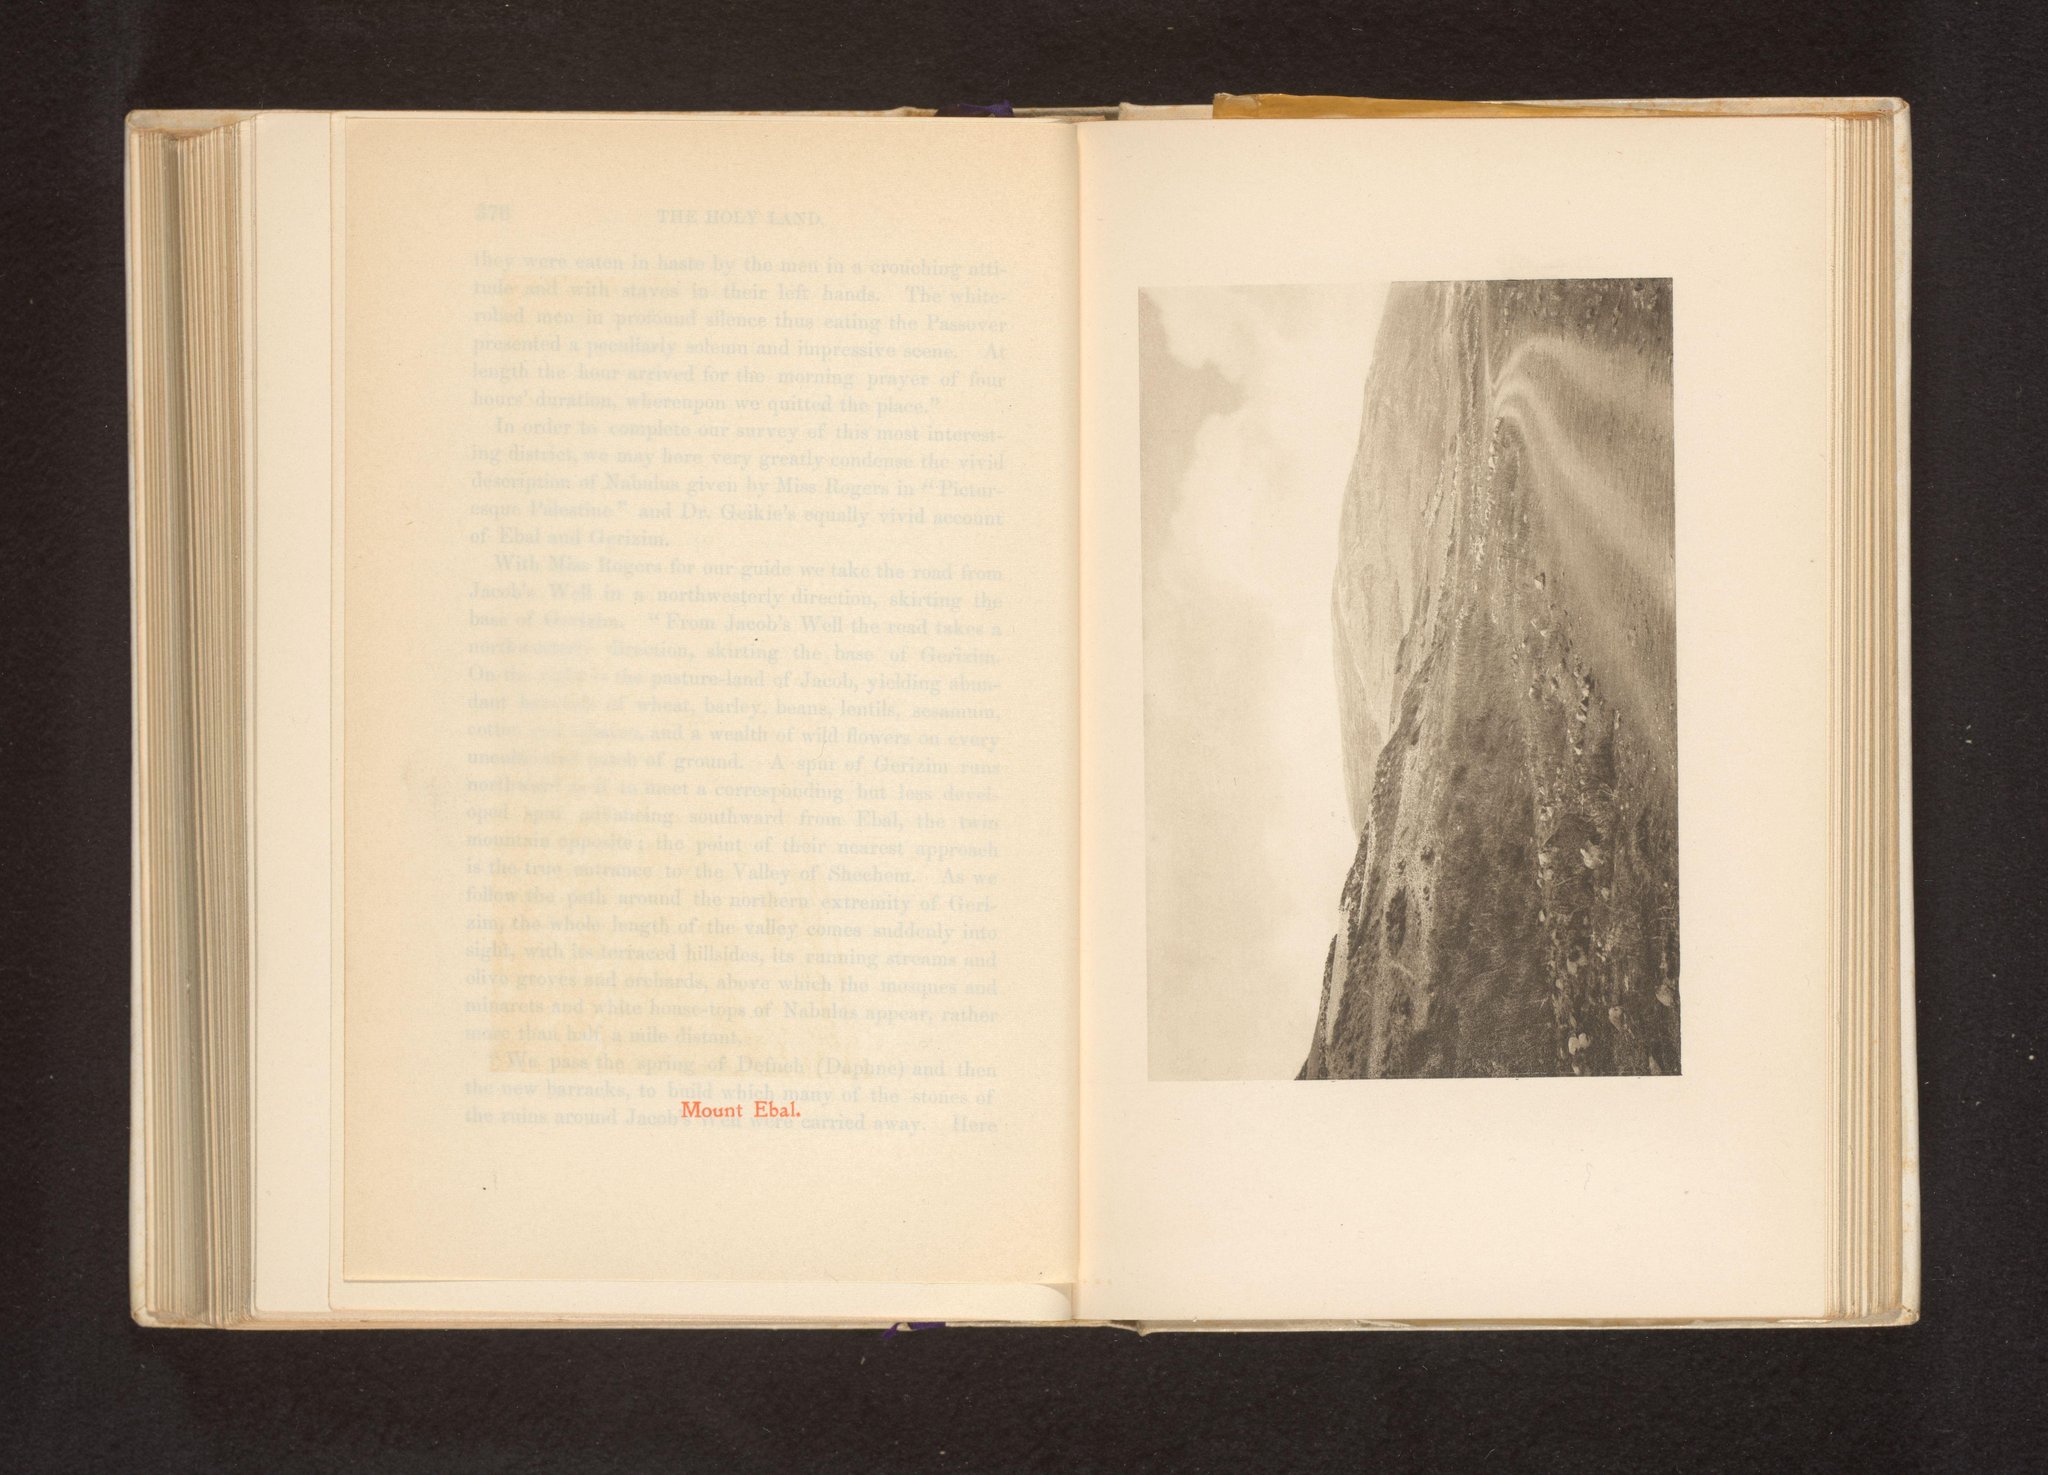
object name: page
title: Gezicht op de berg Ebal te Palestina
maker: Anonymous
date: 1890-1900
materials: paper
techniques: photoaquatint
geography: palestine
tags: mountains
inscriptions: title: ‘Mount Ebal.’